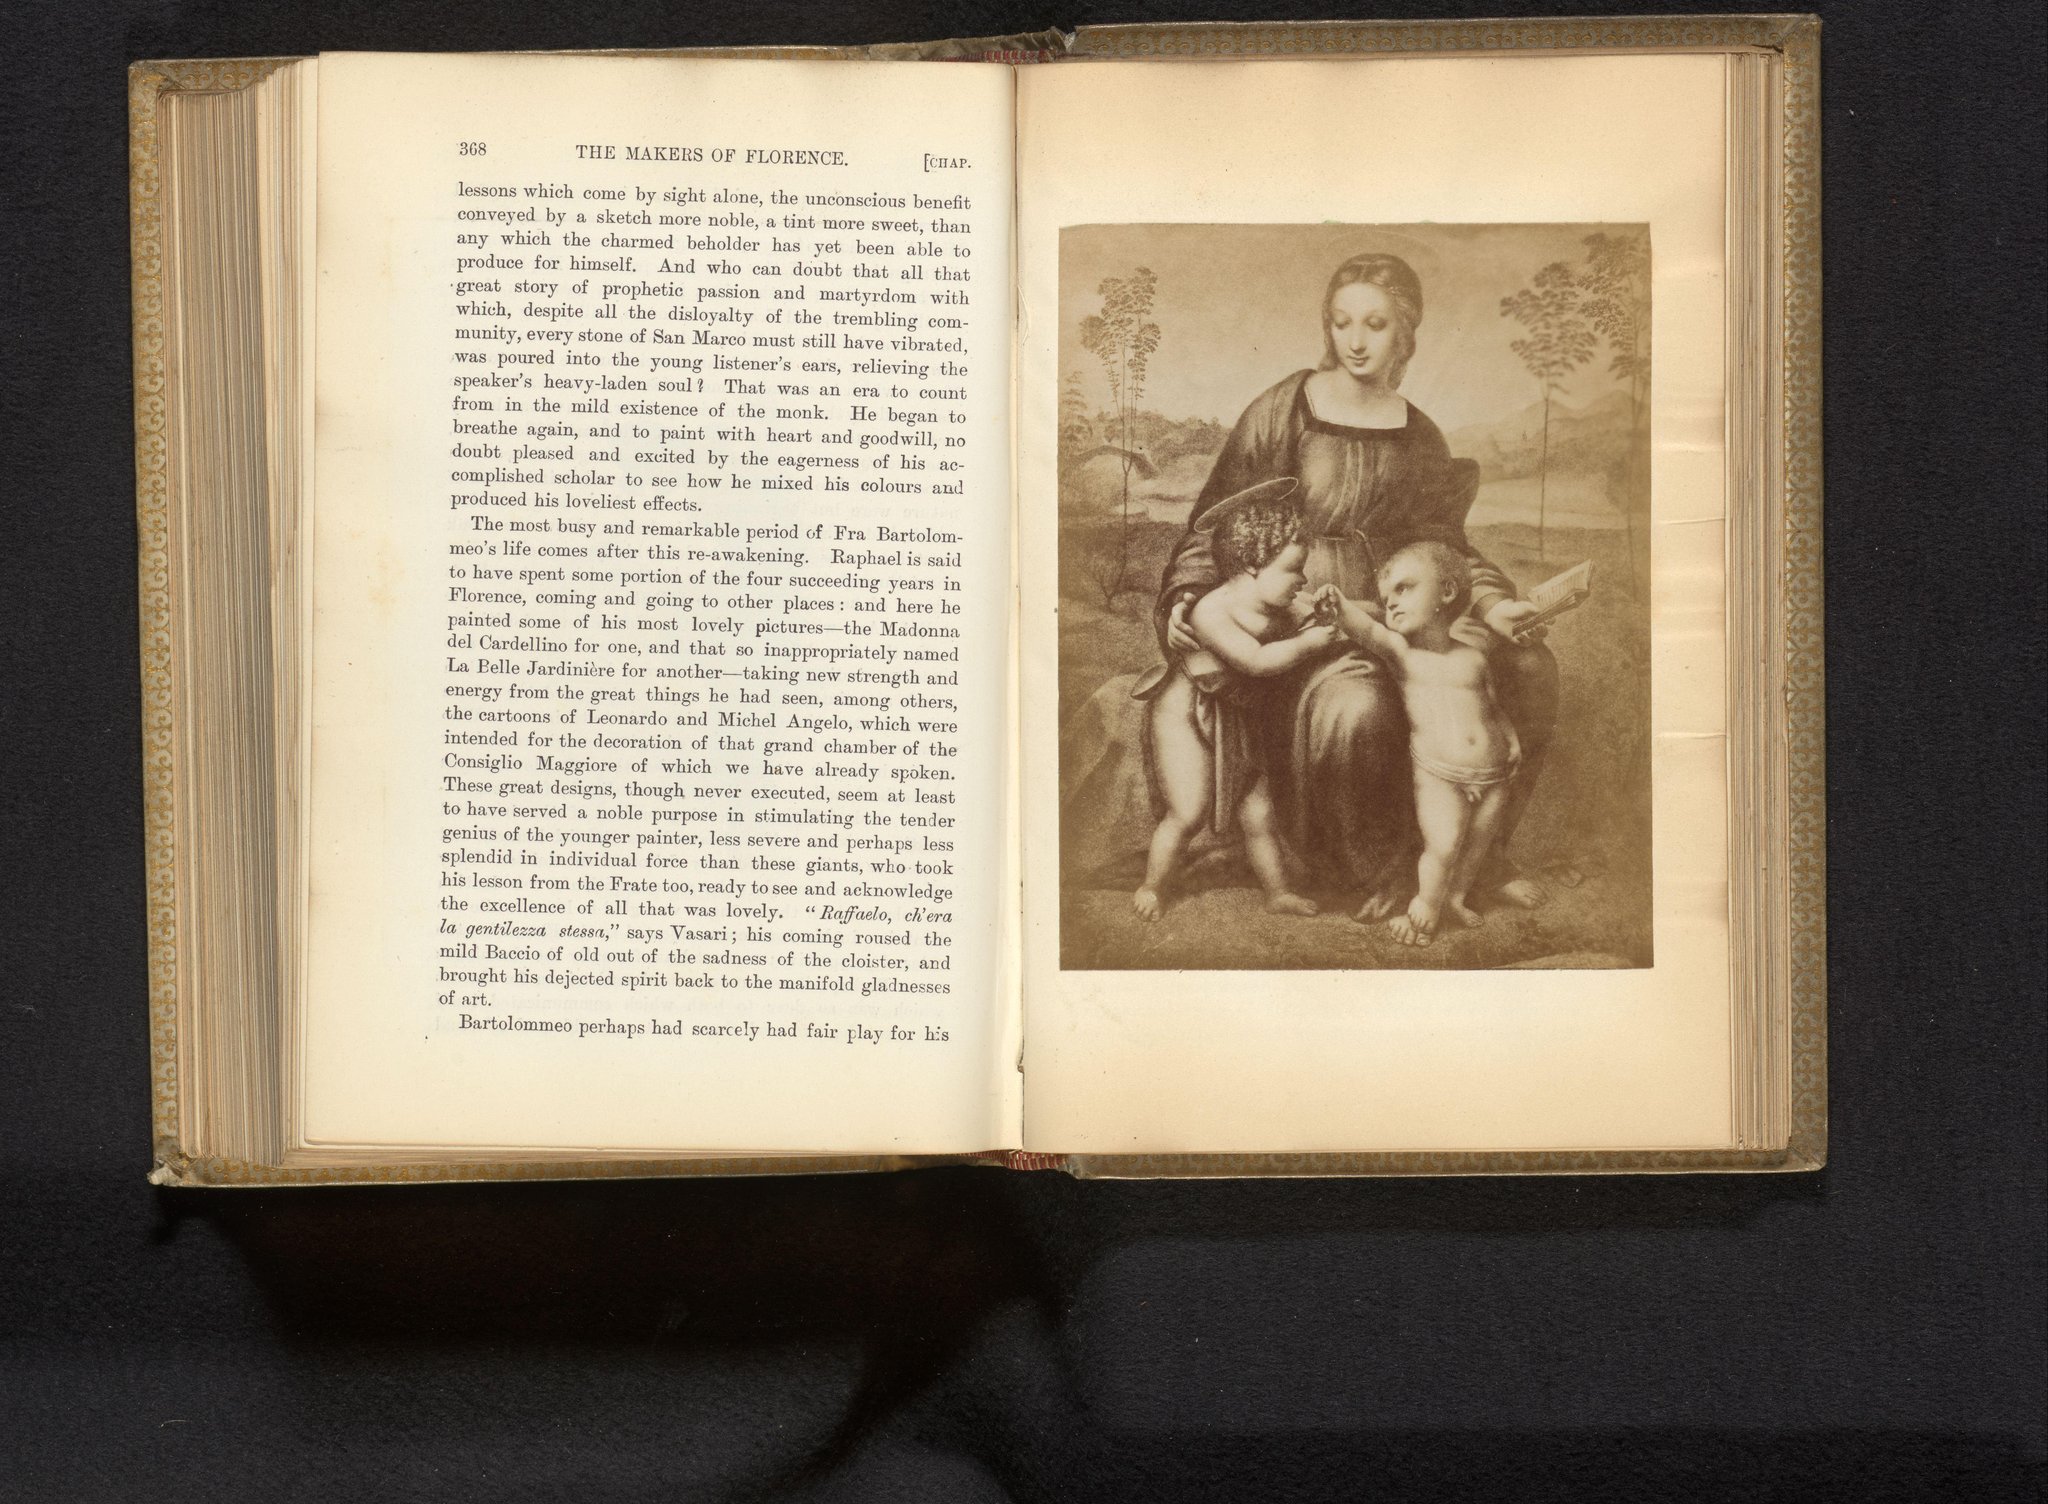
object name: photograph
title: Fotoreproductie van een schilderij, voorstellende de Madonna met de Goudvink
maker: Anonymous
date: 1878-1888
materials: photographic support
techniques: albumen print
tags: john the baptist as child ~ madonna-representations (n.b. secondary notation only), song-birds: finch